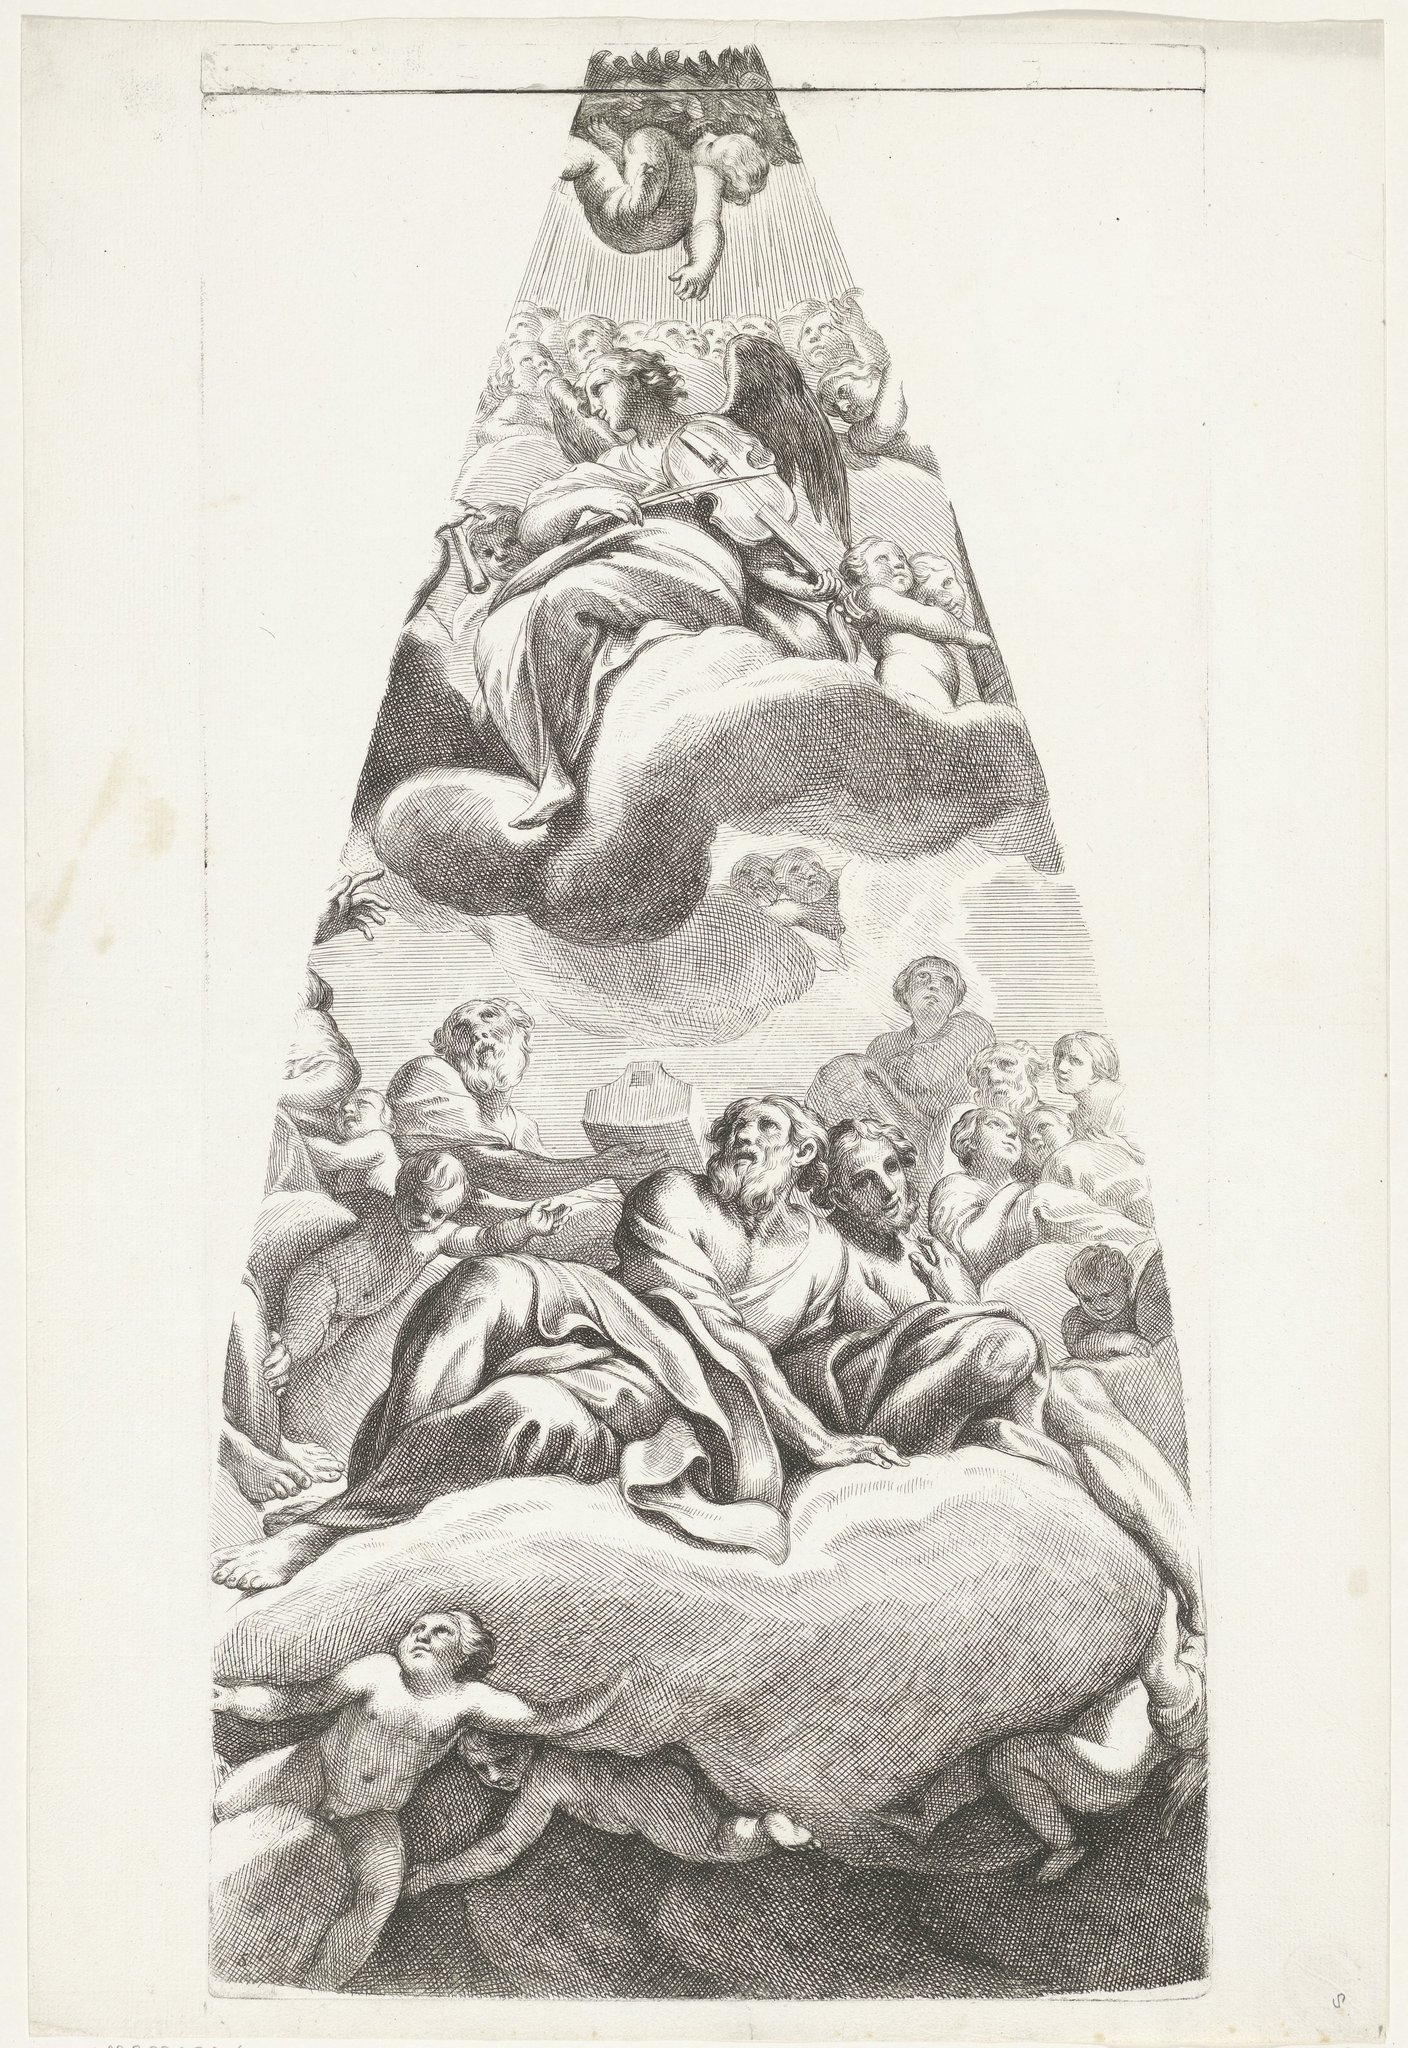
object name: print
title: Hemelvaart van Maria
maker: carlo cesio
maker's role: painter, print maker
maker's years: 1622-1682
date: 1636-1686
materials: paper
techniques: engraving, etching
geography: italy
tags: angels singing, making music, story of noah, groups of persons from the old testament, angels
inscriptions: collector's mark: Lugt 240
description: Prent uit een reeks van 8 prenten naar de fresco's door Giovanni Lanfranco in de koepel van de San Andrea della Valle te Rome.